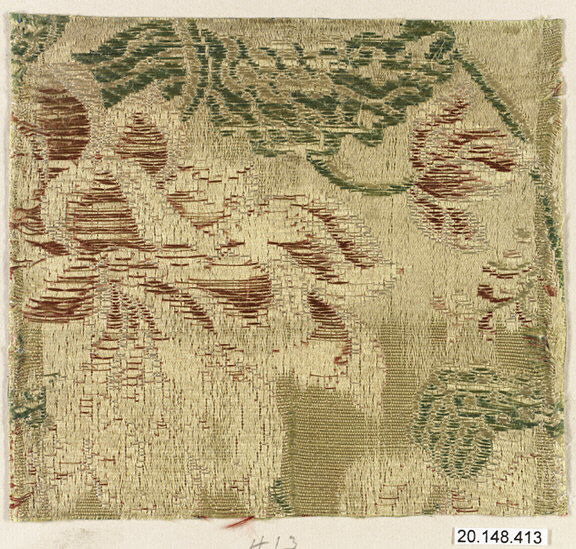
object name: piece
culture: chinese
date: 1701-1800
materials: silk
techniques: compound weave